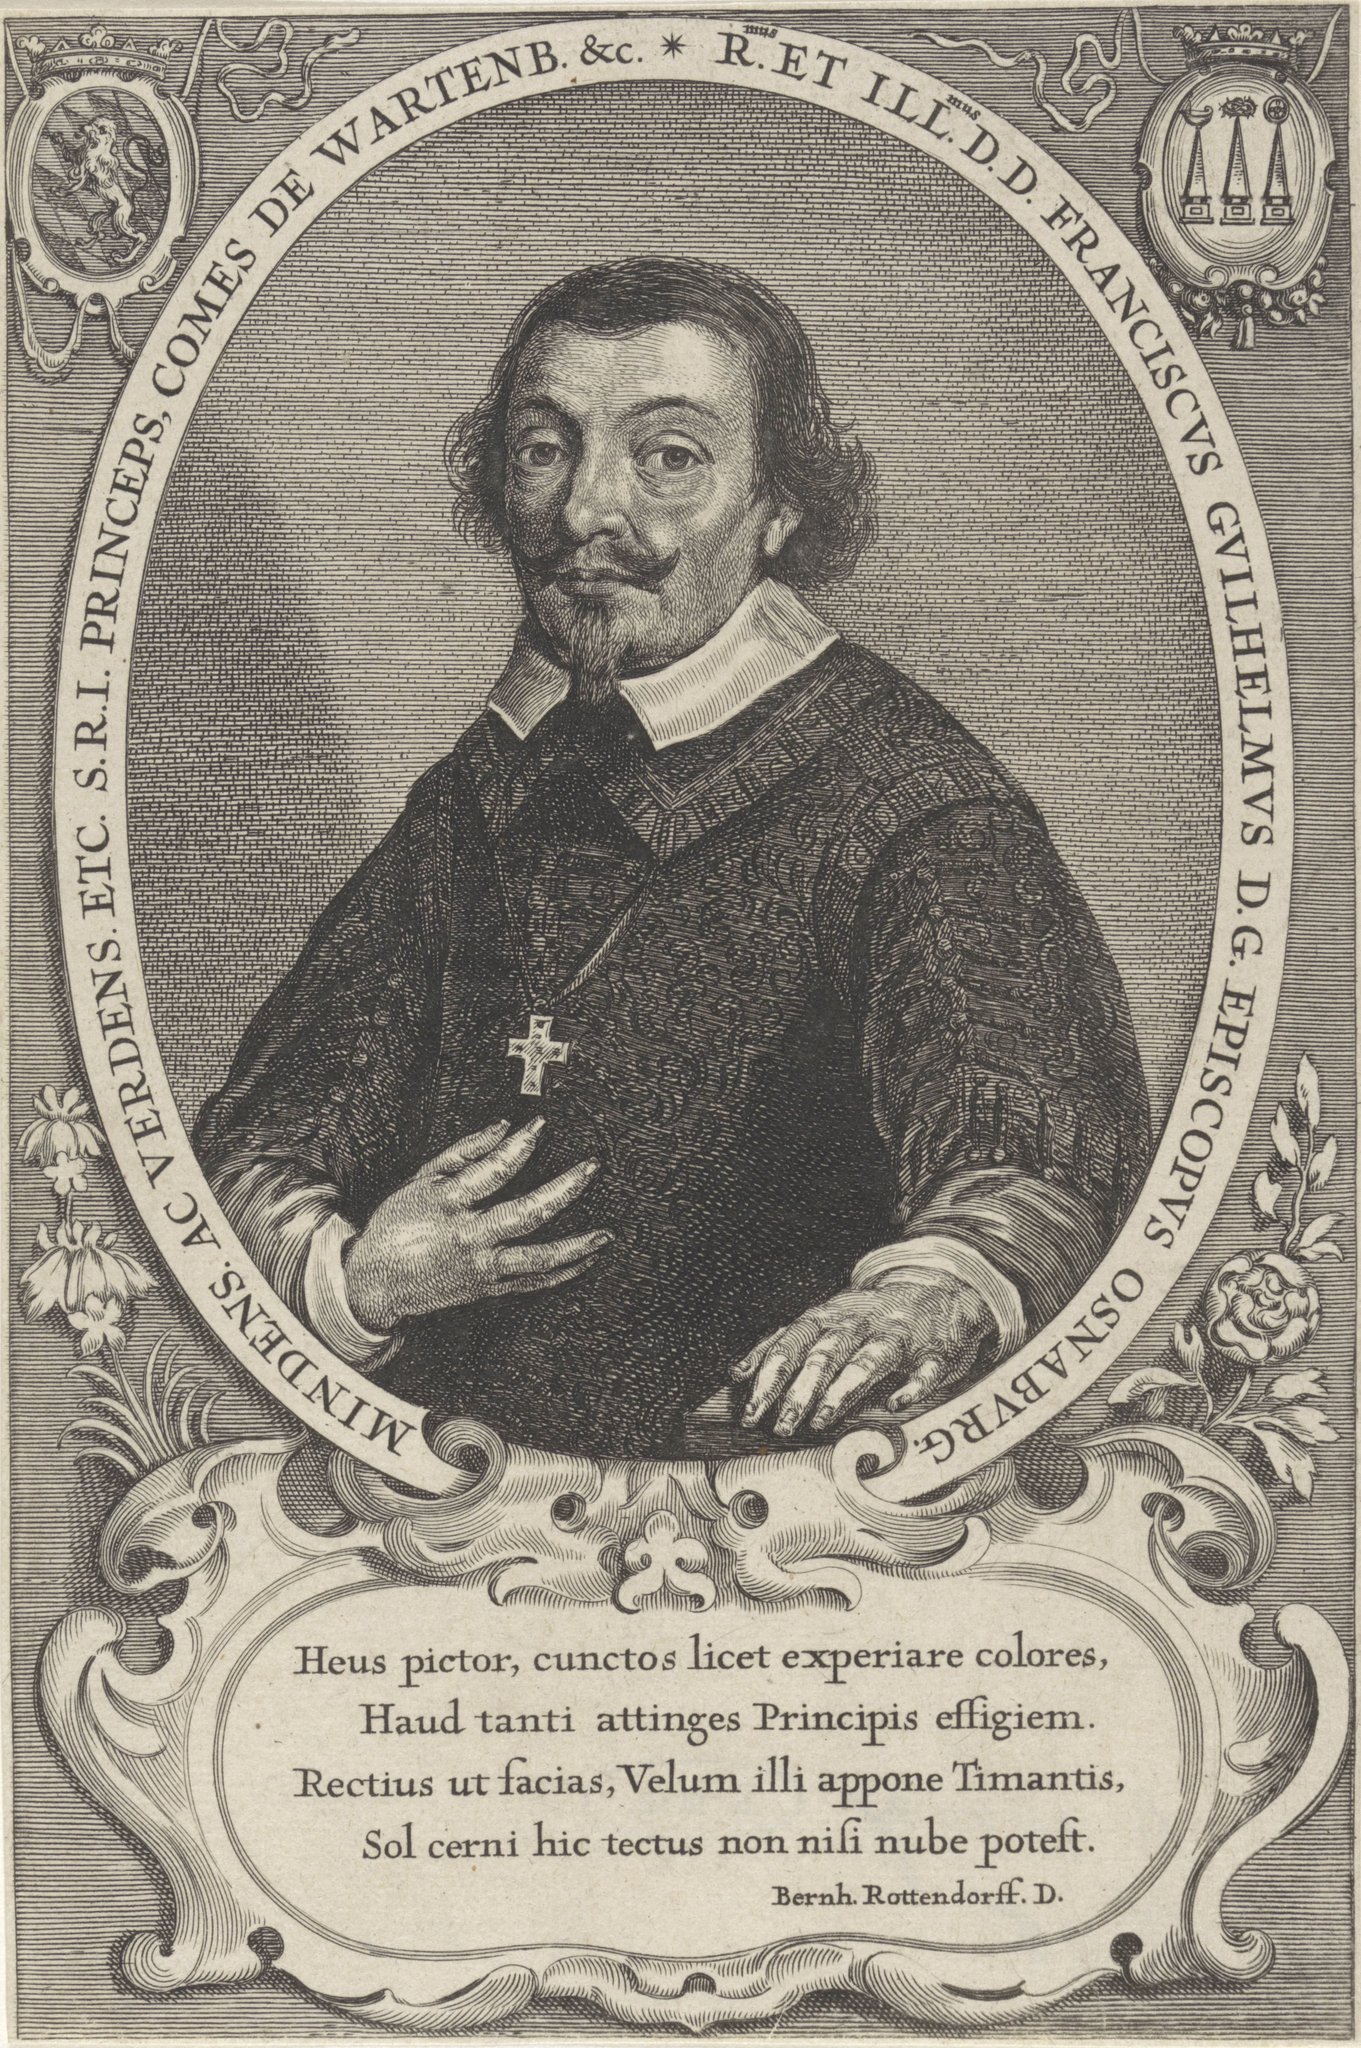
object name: print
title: Portret van Franz Wilhelm von Wartenberg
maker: bernhard rottendorff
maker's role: arts, bibliofiel, raadsheer, schrijver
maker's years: 1594-1670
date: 1625-1637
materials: paper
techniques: engraving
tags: priest, archbishop, bishop, etc. (roman catholic)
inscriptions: collector's mark: Lugt 2228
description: Prent waarschijnlijk uit: Ferrari, Giovanni Battista. Flora, seu De florum cultura. Amsterdam: Johannes Janssonius, 1664. De prent wordt in de literatuur zowel aan Jonas Suyderhoef als aan Lucas Kilian toegeschreven.